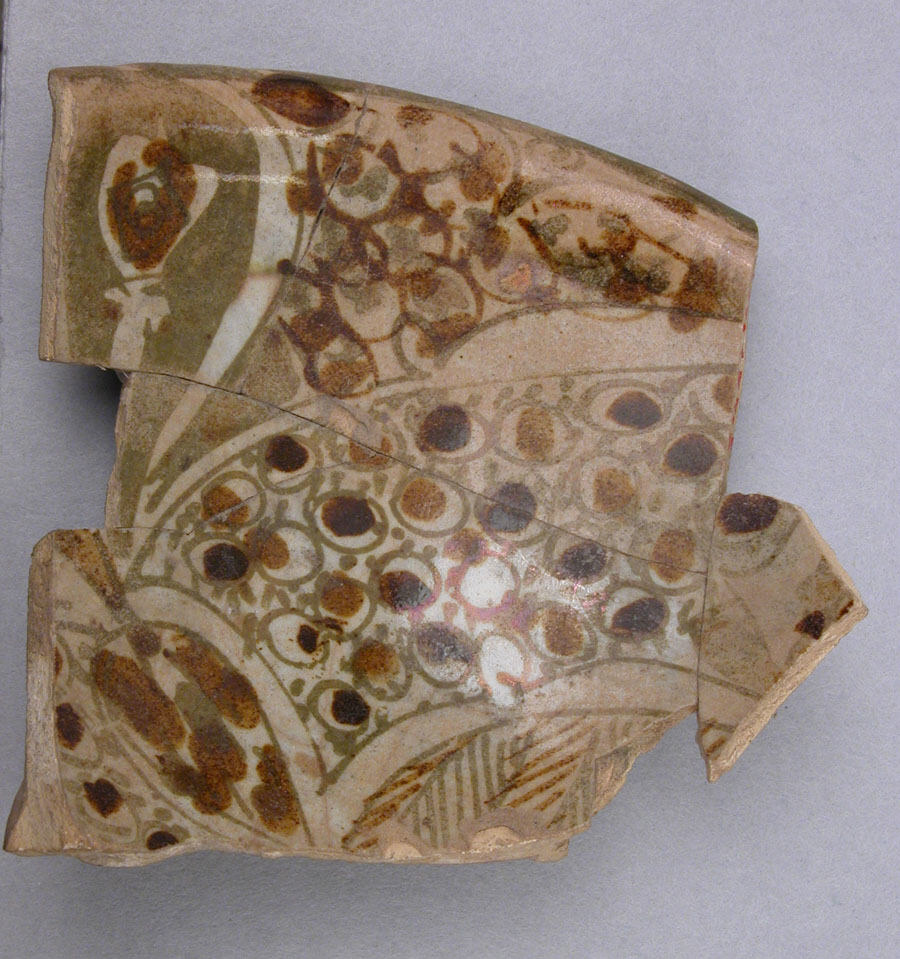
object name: fragment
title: Ceramic Fragment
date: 801-1000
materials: earthenware, glaze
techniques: luster painting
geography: iran